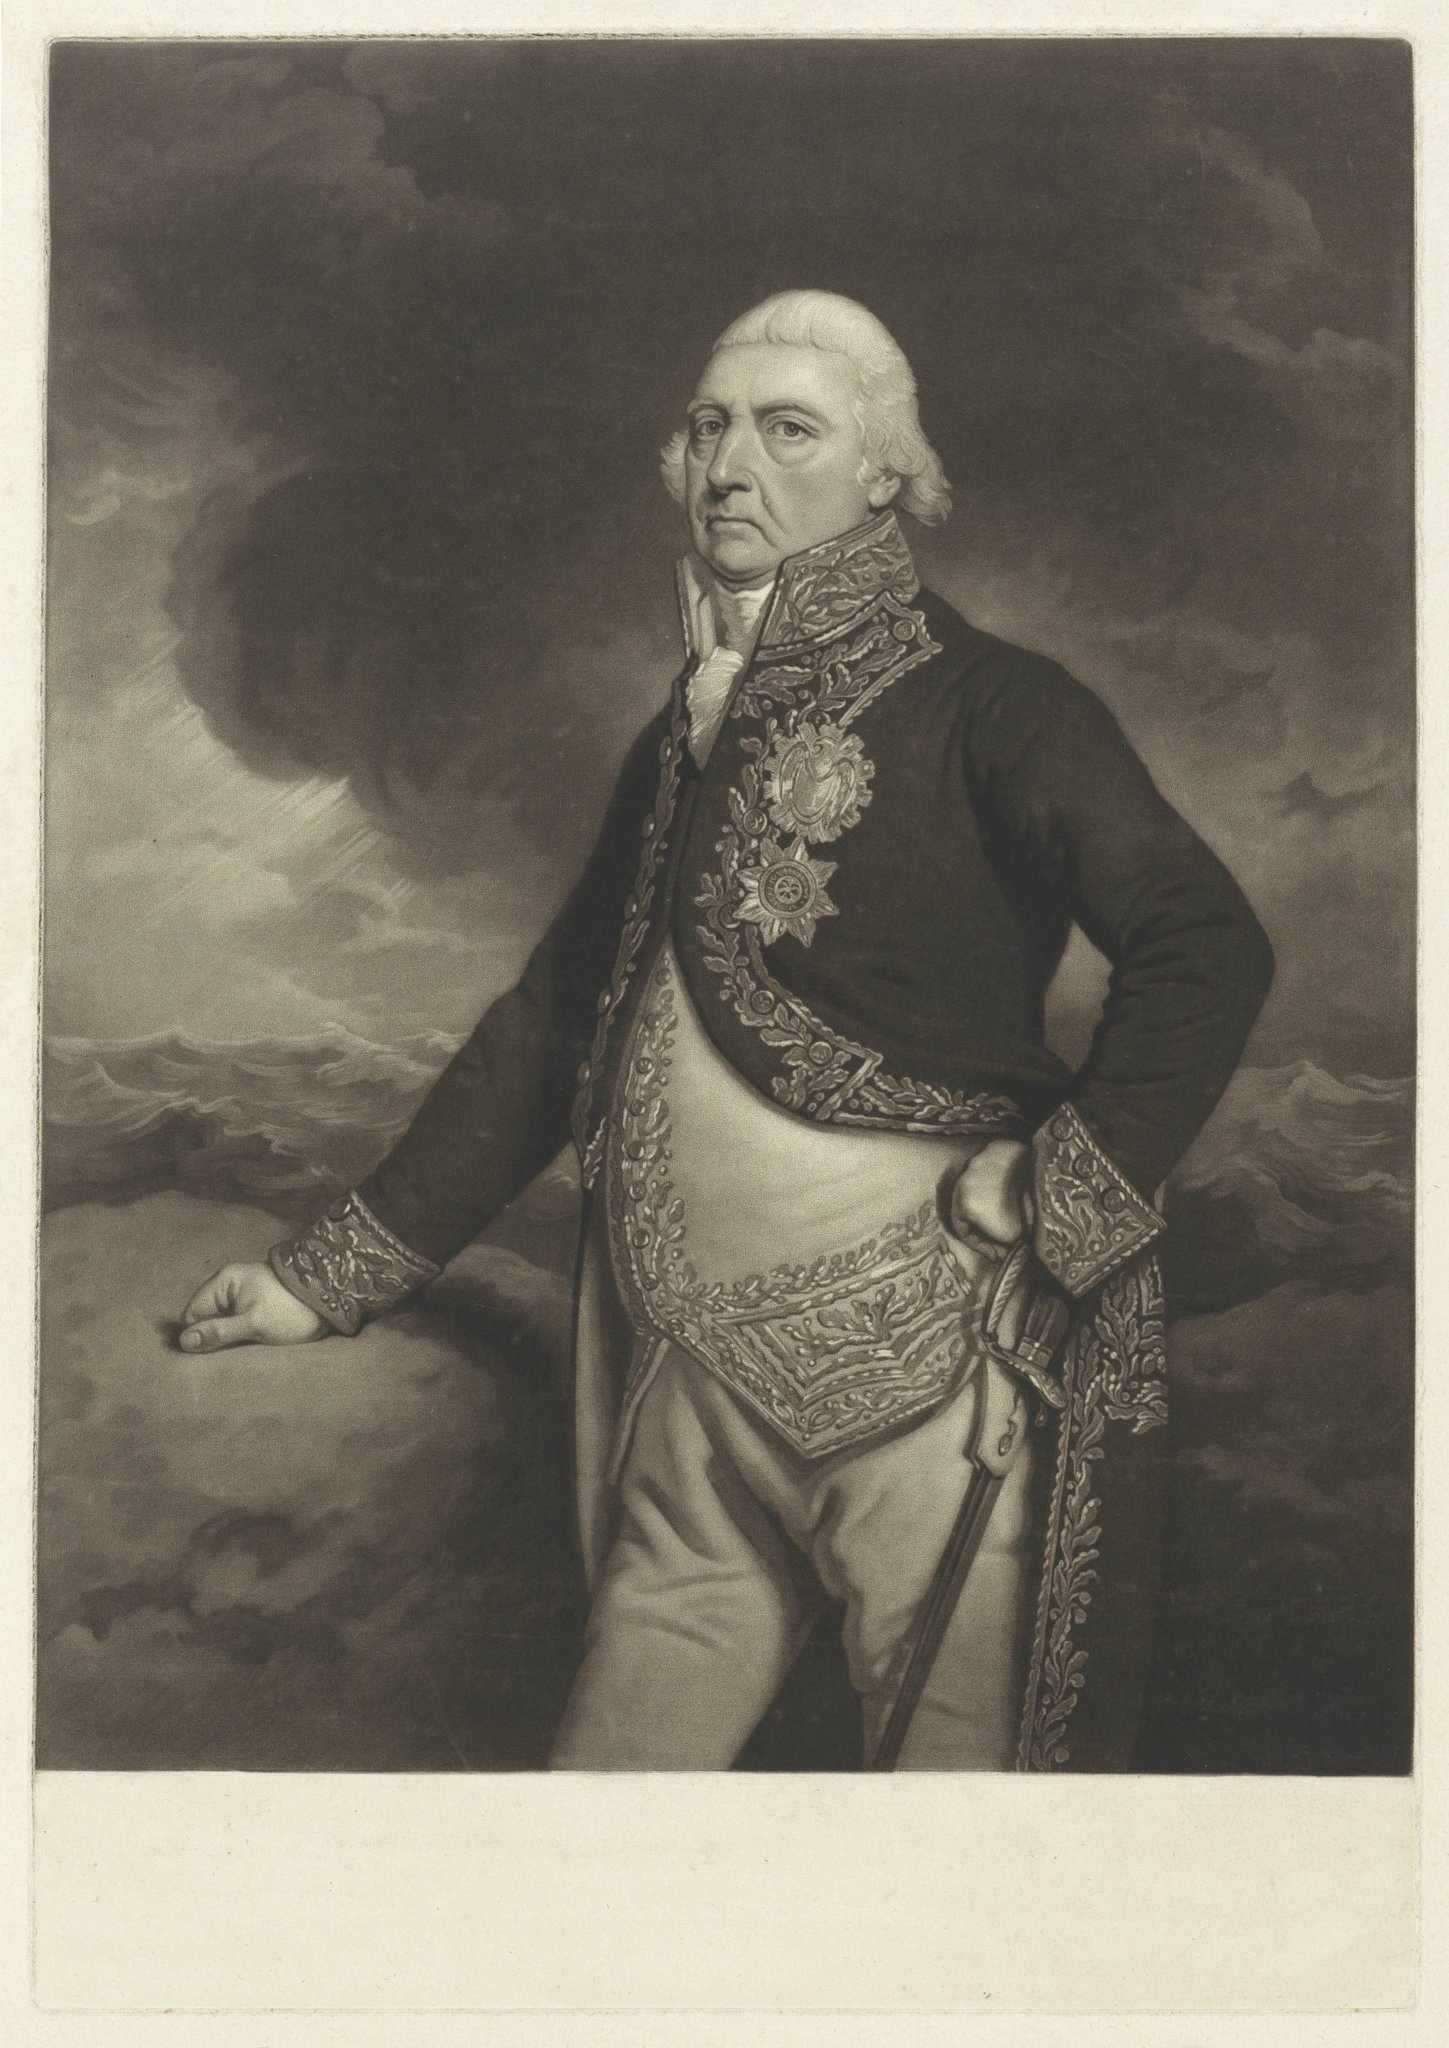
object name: print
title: Portret van admiraal Jan Hendrik van Kinsbergen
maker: charles howard hodges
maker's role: draughtsman, painter, print maker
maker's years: 1764-1837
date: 1788-1837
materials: paper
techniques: engraving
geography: netherlands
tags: jonkheer jan hendrik van kinsbergen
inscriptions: collector's mark: Lugt 2228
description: Jan Hendrik van Kinsbergen, vice-admiraal en buitengewoon maarschalk der Hollandse zeemacht, met een hand in de zij.